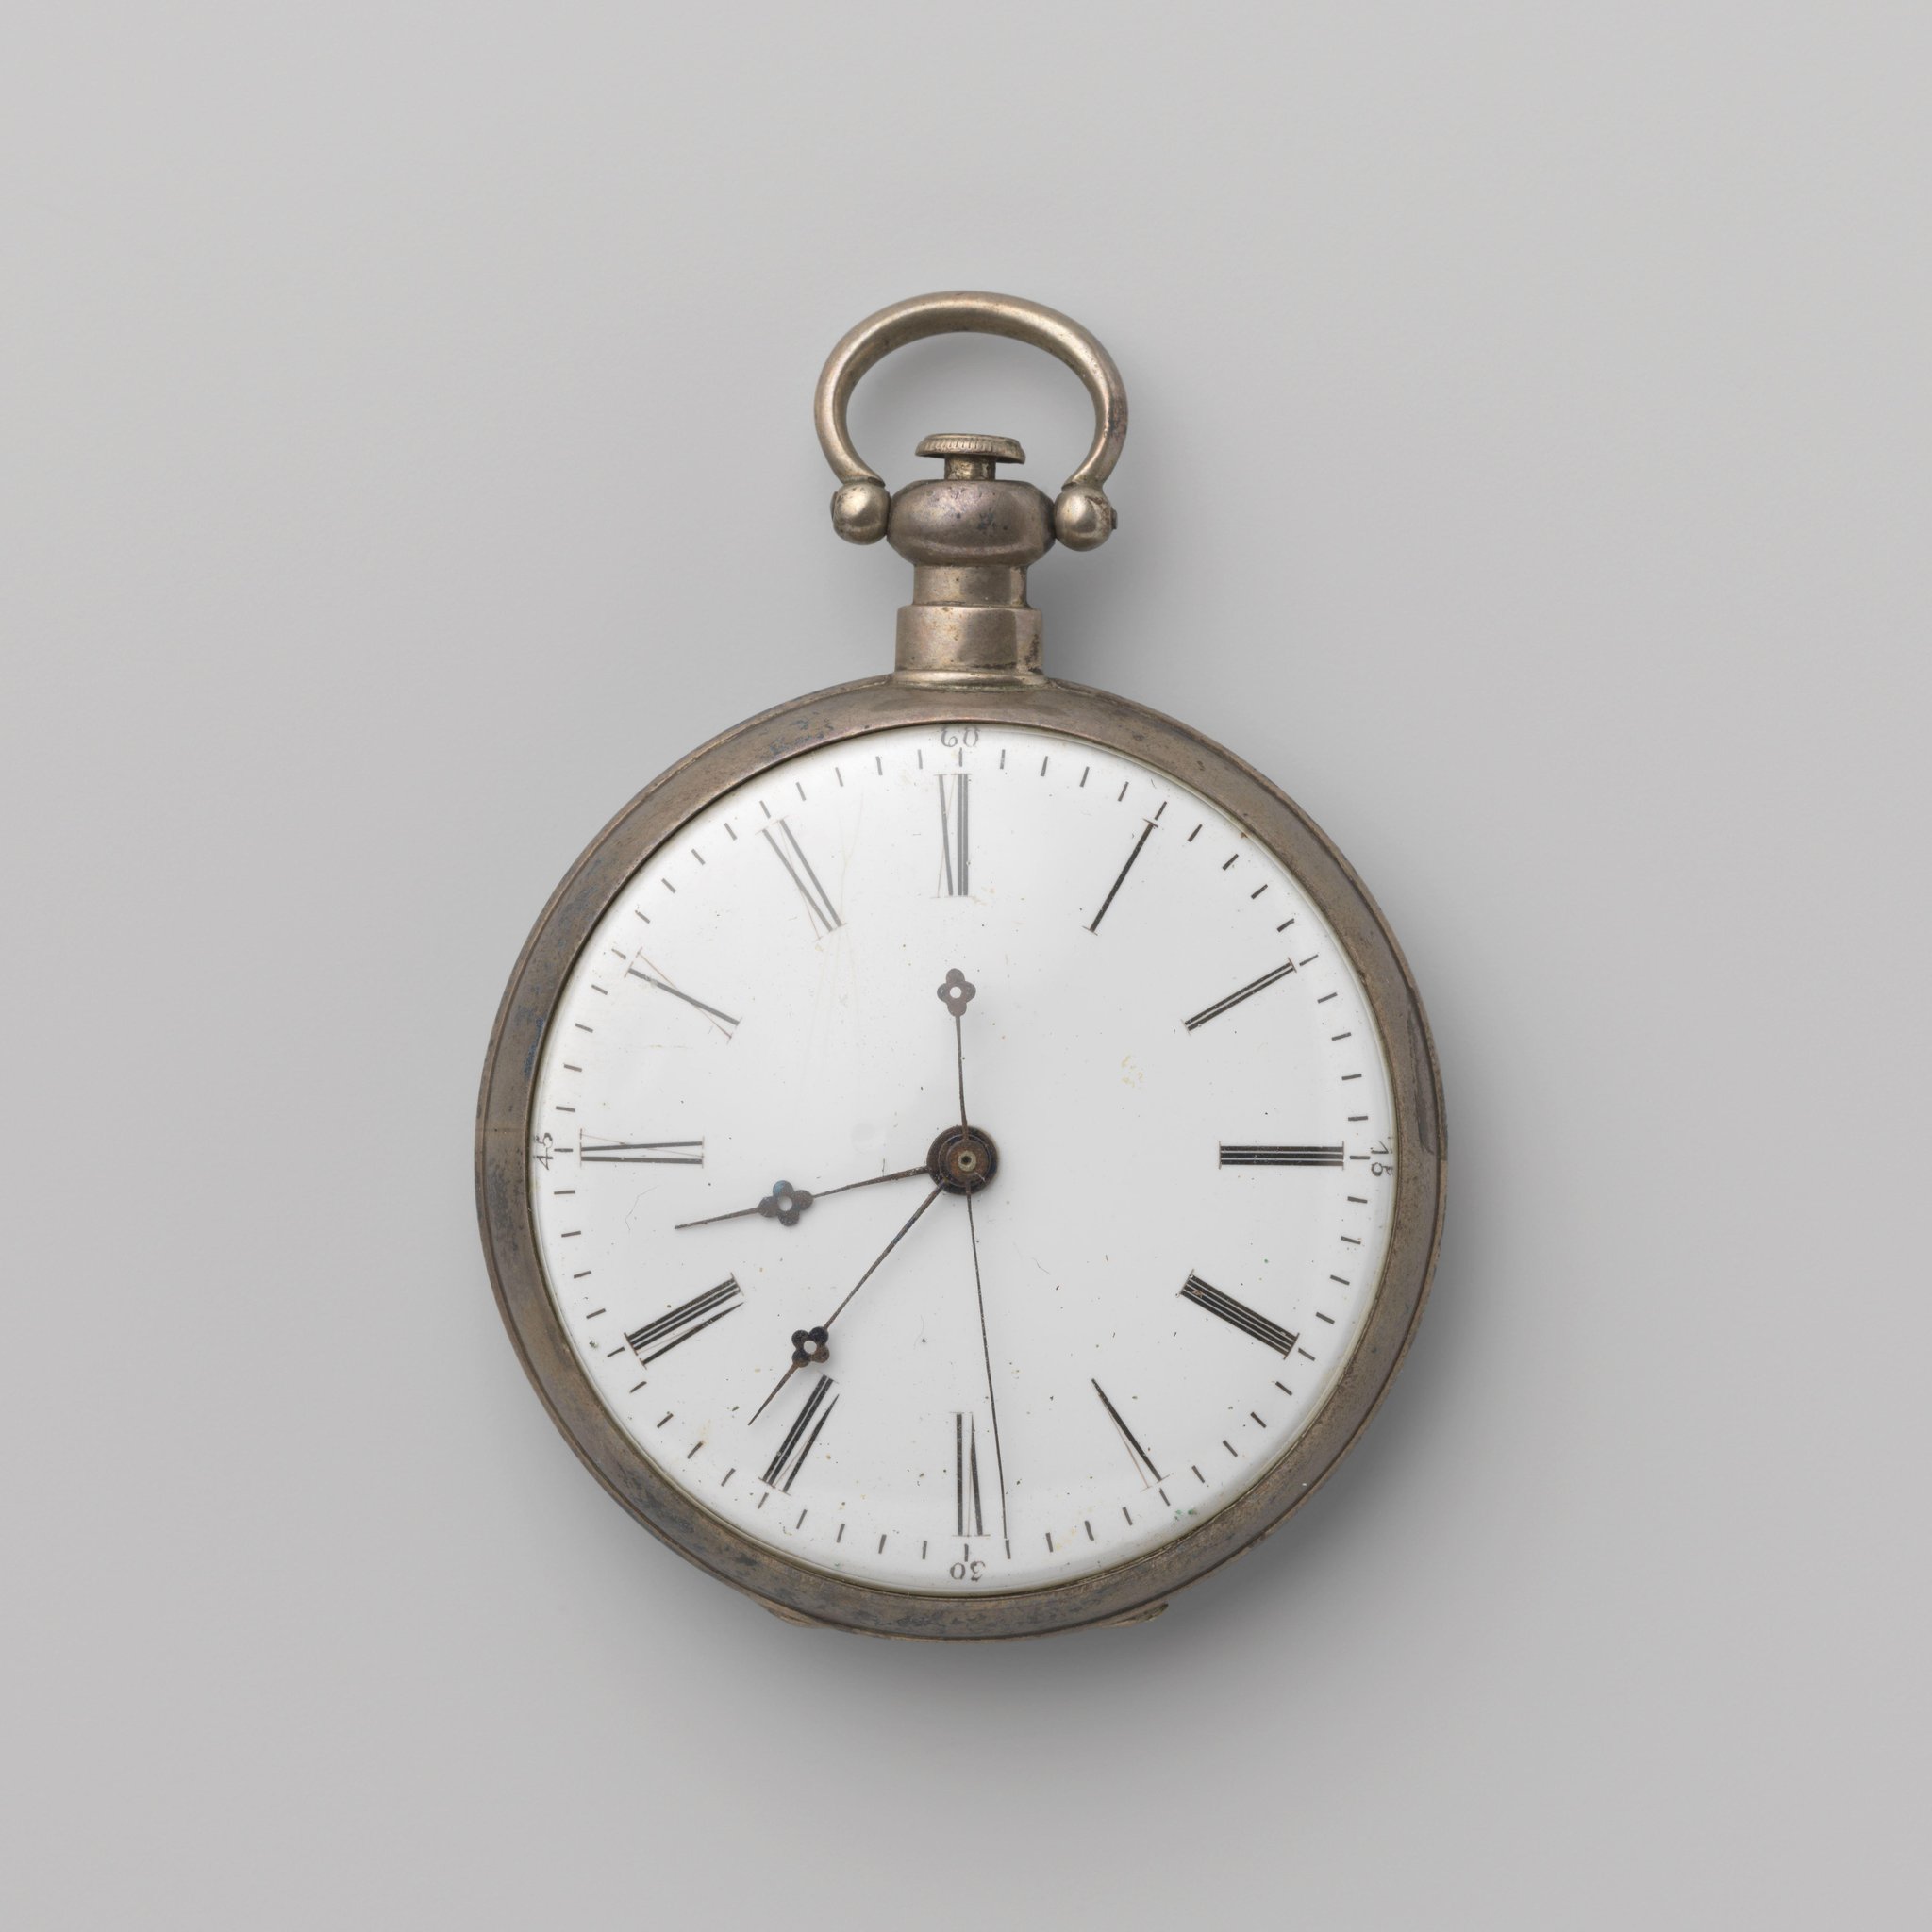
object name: wrist watch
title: Herenhorloge van zilver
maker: Anonymous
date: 1870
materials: silver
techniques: enameling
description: Herenhorloge, met duplexgang, van zilver met gladde achterbodem en wit geëmailleerde wijzerplaat.